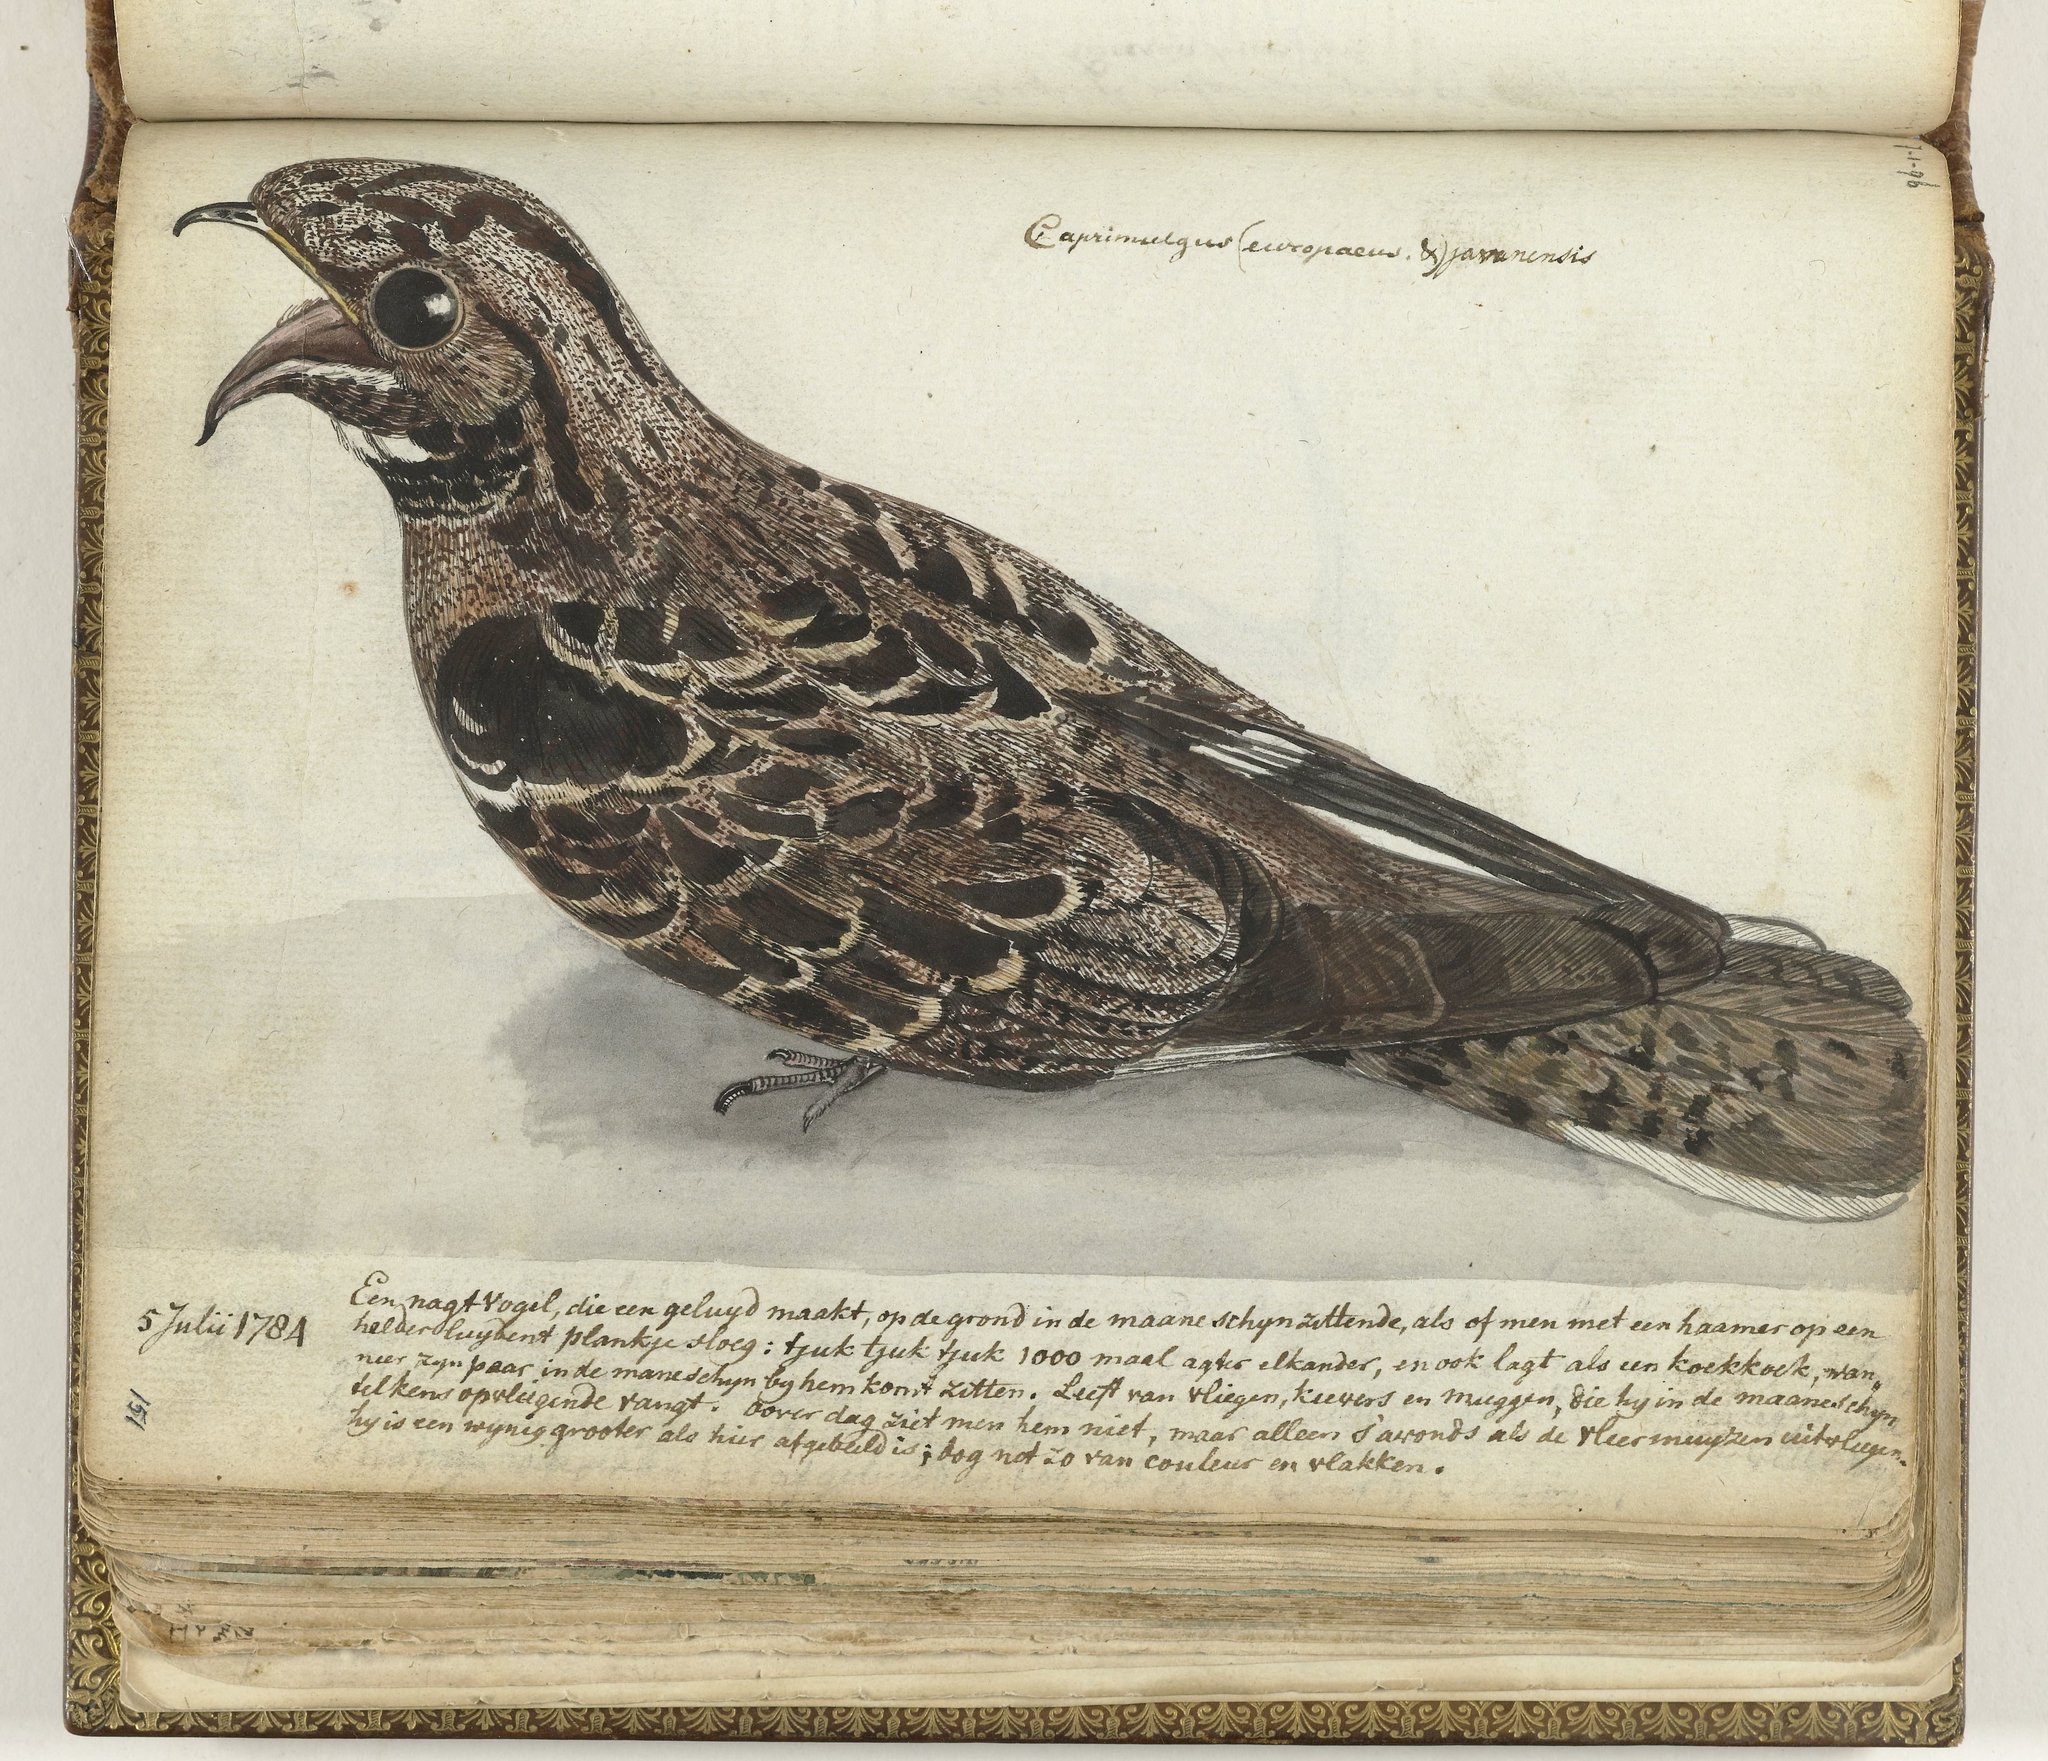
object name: drawing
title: Nightjar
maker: jan brandes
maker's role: draughtsman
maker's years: 1743-1808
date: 1784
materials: paper, pencil, watercolor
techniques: brush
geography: jakarta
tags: birds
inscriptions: date: ‘5 Julij 1784’, inscription: ‘Een nagtvogel, die een geluyd maakt, op de grond in de maane schyn zittende, als of men met een haamer op een helderluydent plankje sloeg: tjuk tjuk tjuk 1000 maal agter elkander, en ook lagt als een koekkoek, wanneer zyn paar in de maneschyn by hem komt zitten. Leeft van vliegen, keevers en muggen, die hy in de maaneschyn telkens opvliegende vangt. Ooverdag ziet men hem niet, maar alleen s'avonds als de vleermuyzen uitvliegen. hy is een wynig grooter als hier afgebeeld is; dog niet zo van couleur en vlakken.’, inscription: ‘Caprimulgus (europaeus &) javanensis’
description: Kleurtekening van een vogel, gezien van boven, iets van opzij. Met opschrift. Onderdeel uit het schetsboek van Jan Brandes, dl. 1 (1808), p. 151.